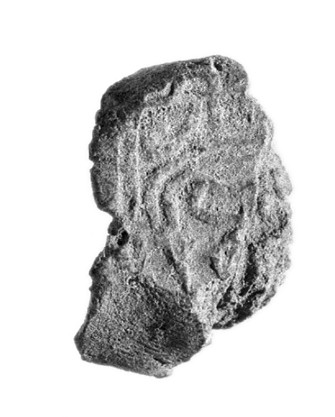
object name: sealing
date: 1981-1640 BCE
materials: mud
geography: egypt